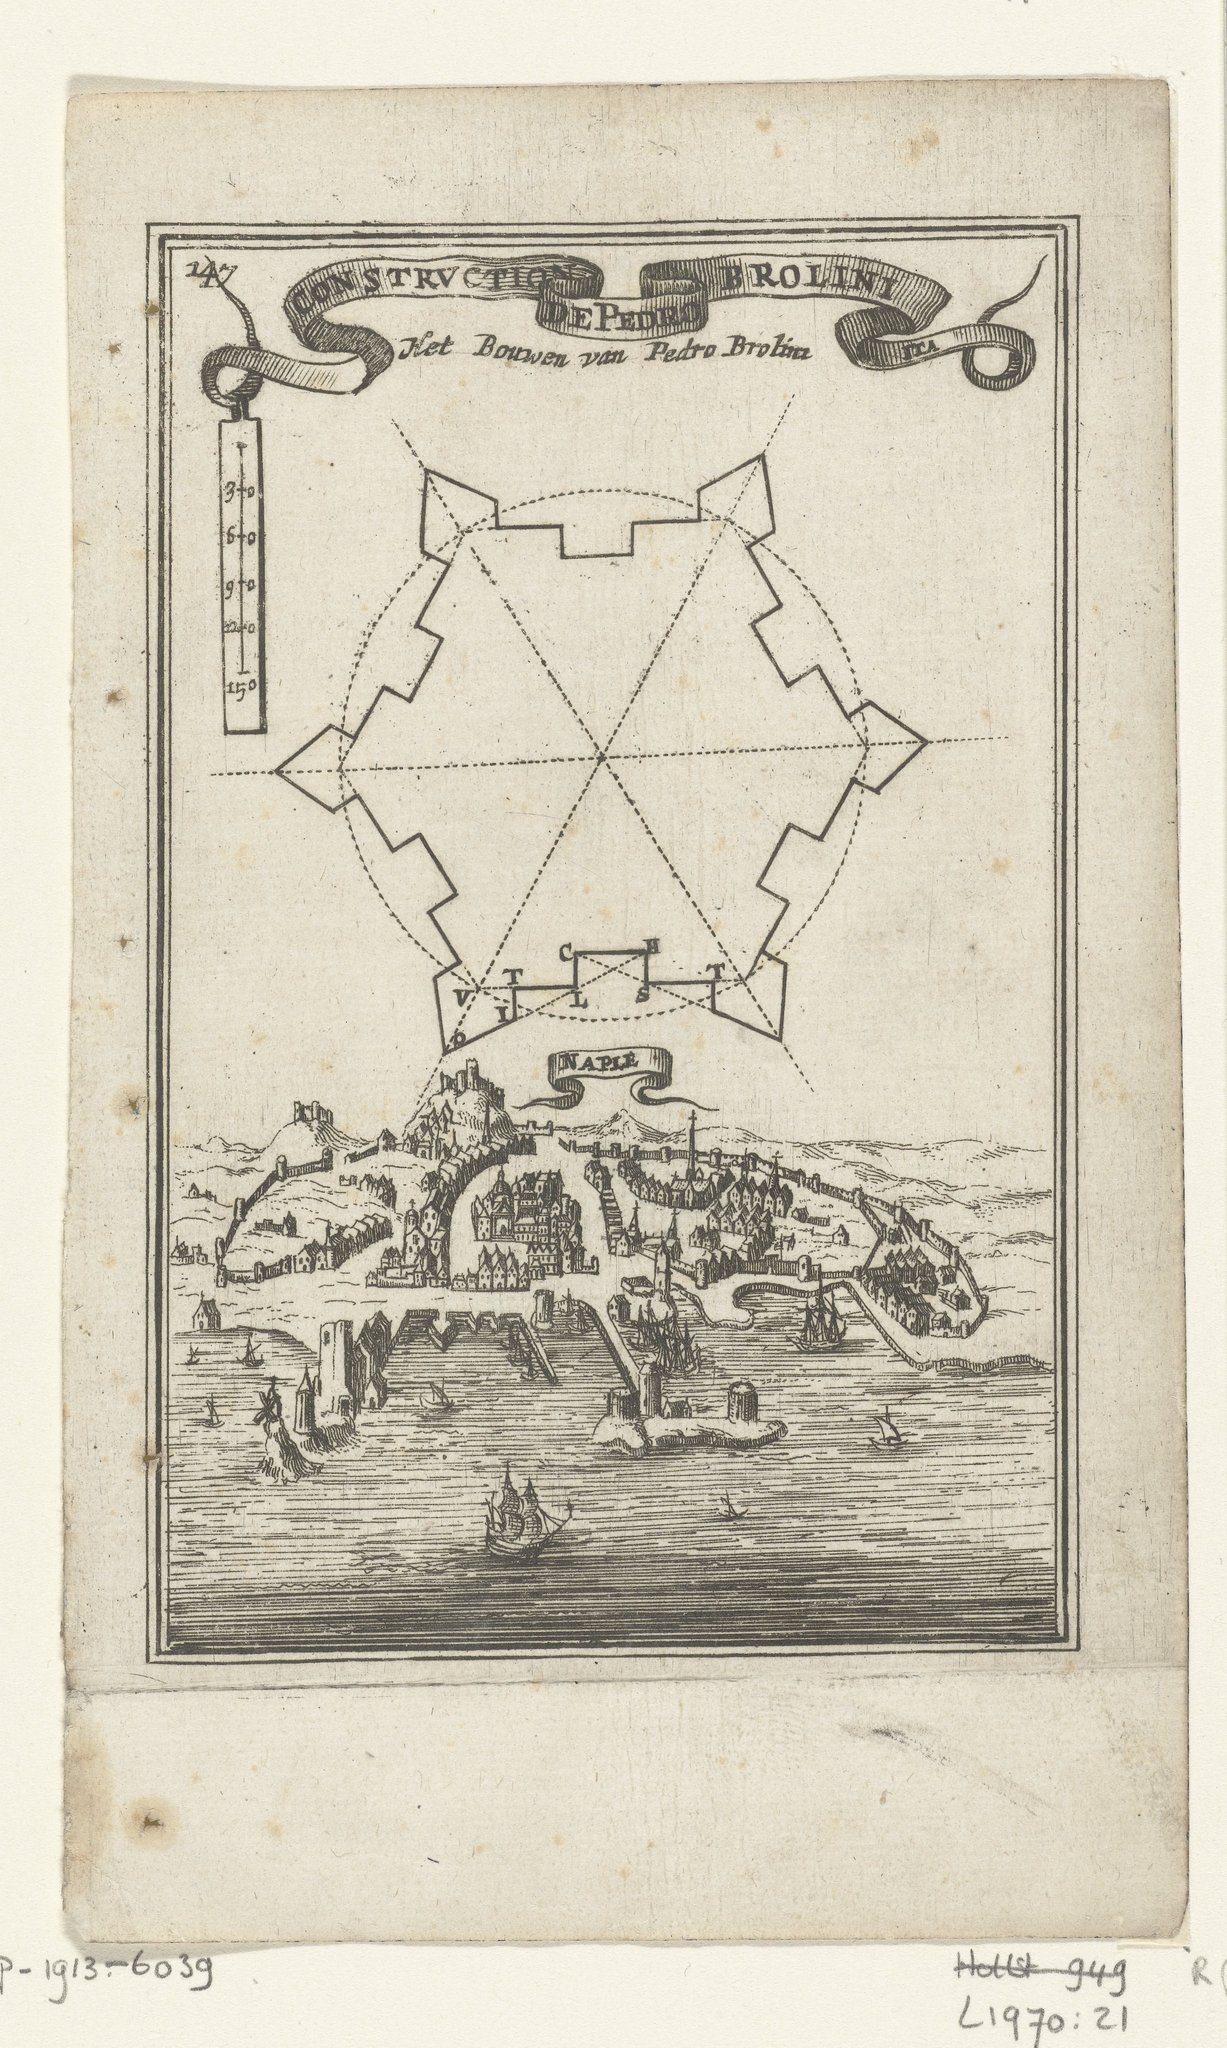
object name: print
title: Illustratie voor 'Den Arbeid van Mars' van Allain Manesson Mallet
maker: romeyn de hooghe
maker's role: draughtsman, goldsmith, painter, print maker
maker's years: 1645-1708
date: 1672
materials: paper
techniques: etching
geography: amsterdam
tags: ships (in general), sea (seascape), fortifications, military engineering, prospect of city, town panorama, silhouette of city, mathematics, naples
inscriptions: collector's mark: Lugt 2228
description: Grondplan voor een vesting, fort of versterking (zeshoek). Daaronder een gezicht op een stad aan zee (Napels). In de hoek linksboven het cijfer 147 (= het nummer van de pagina in het boek waartegenover de illustratie geplaatst is).